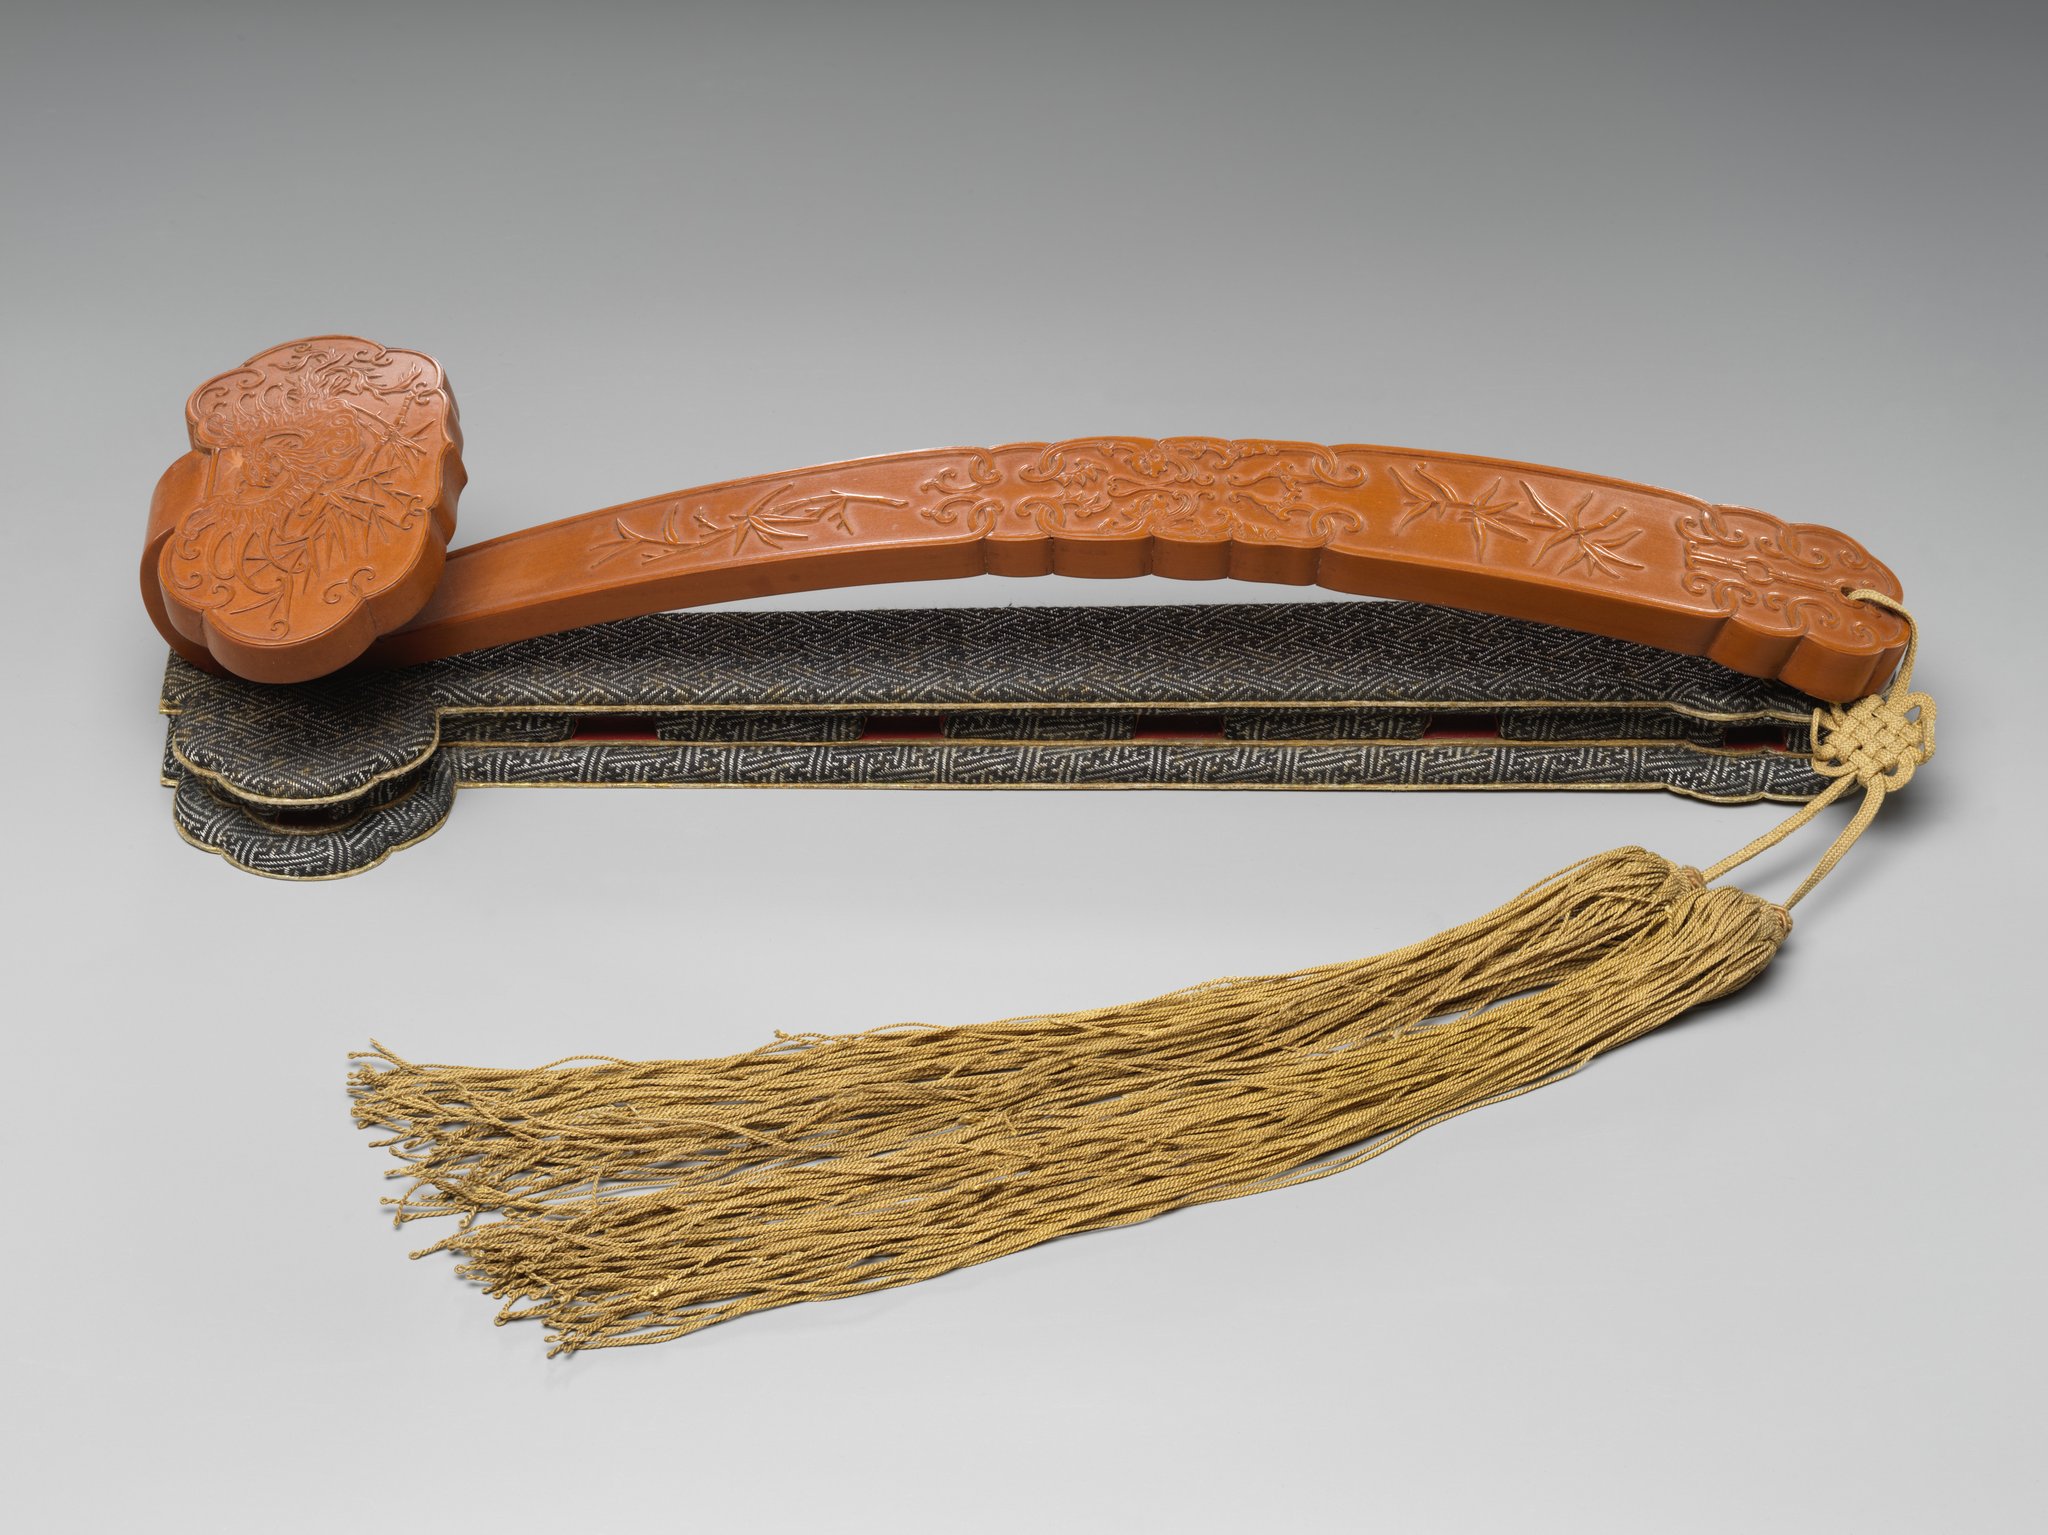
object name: ruyi scepter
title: Ruyi scepter with poem composed by the Qianlong Emperor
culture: chinese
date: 1734-1766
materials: bamboo, silk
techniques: veneering